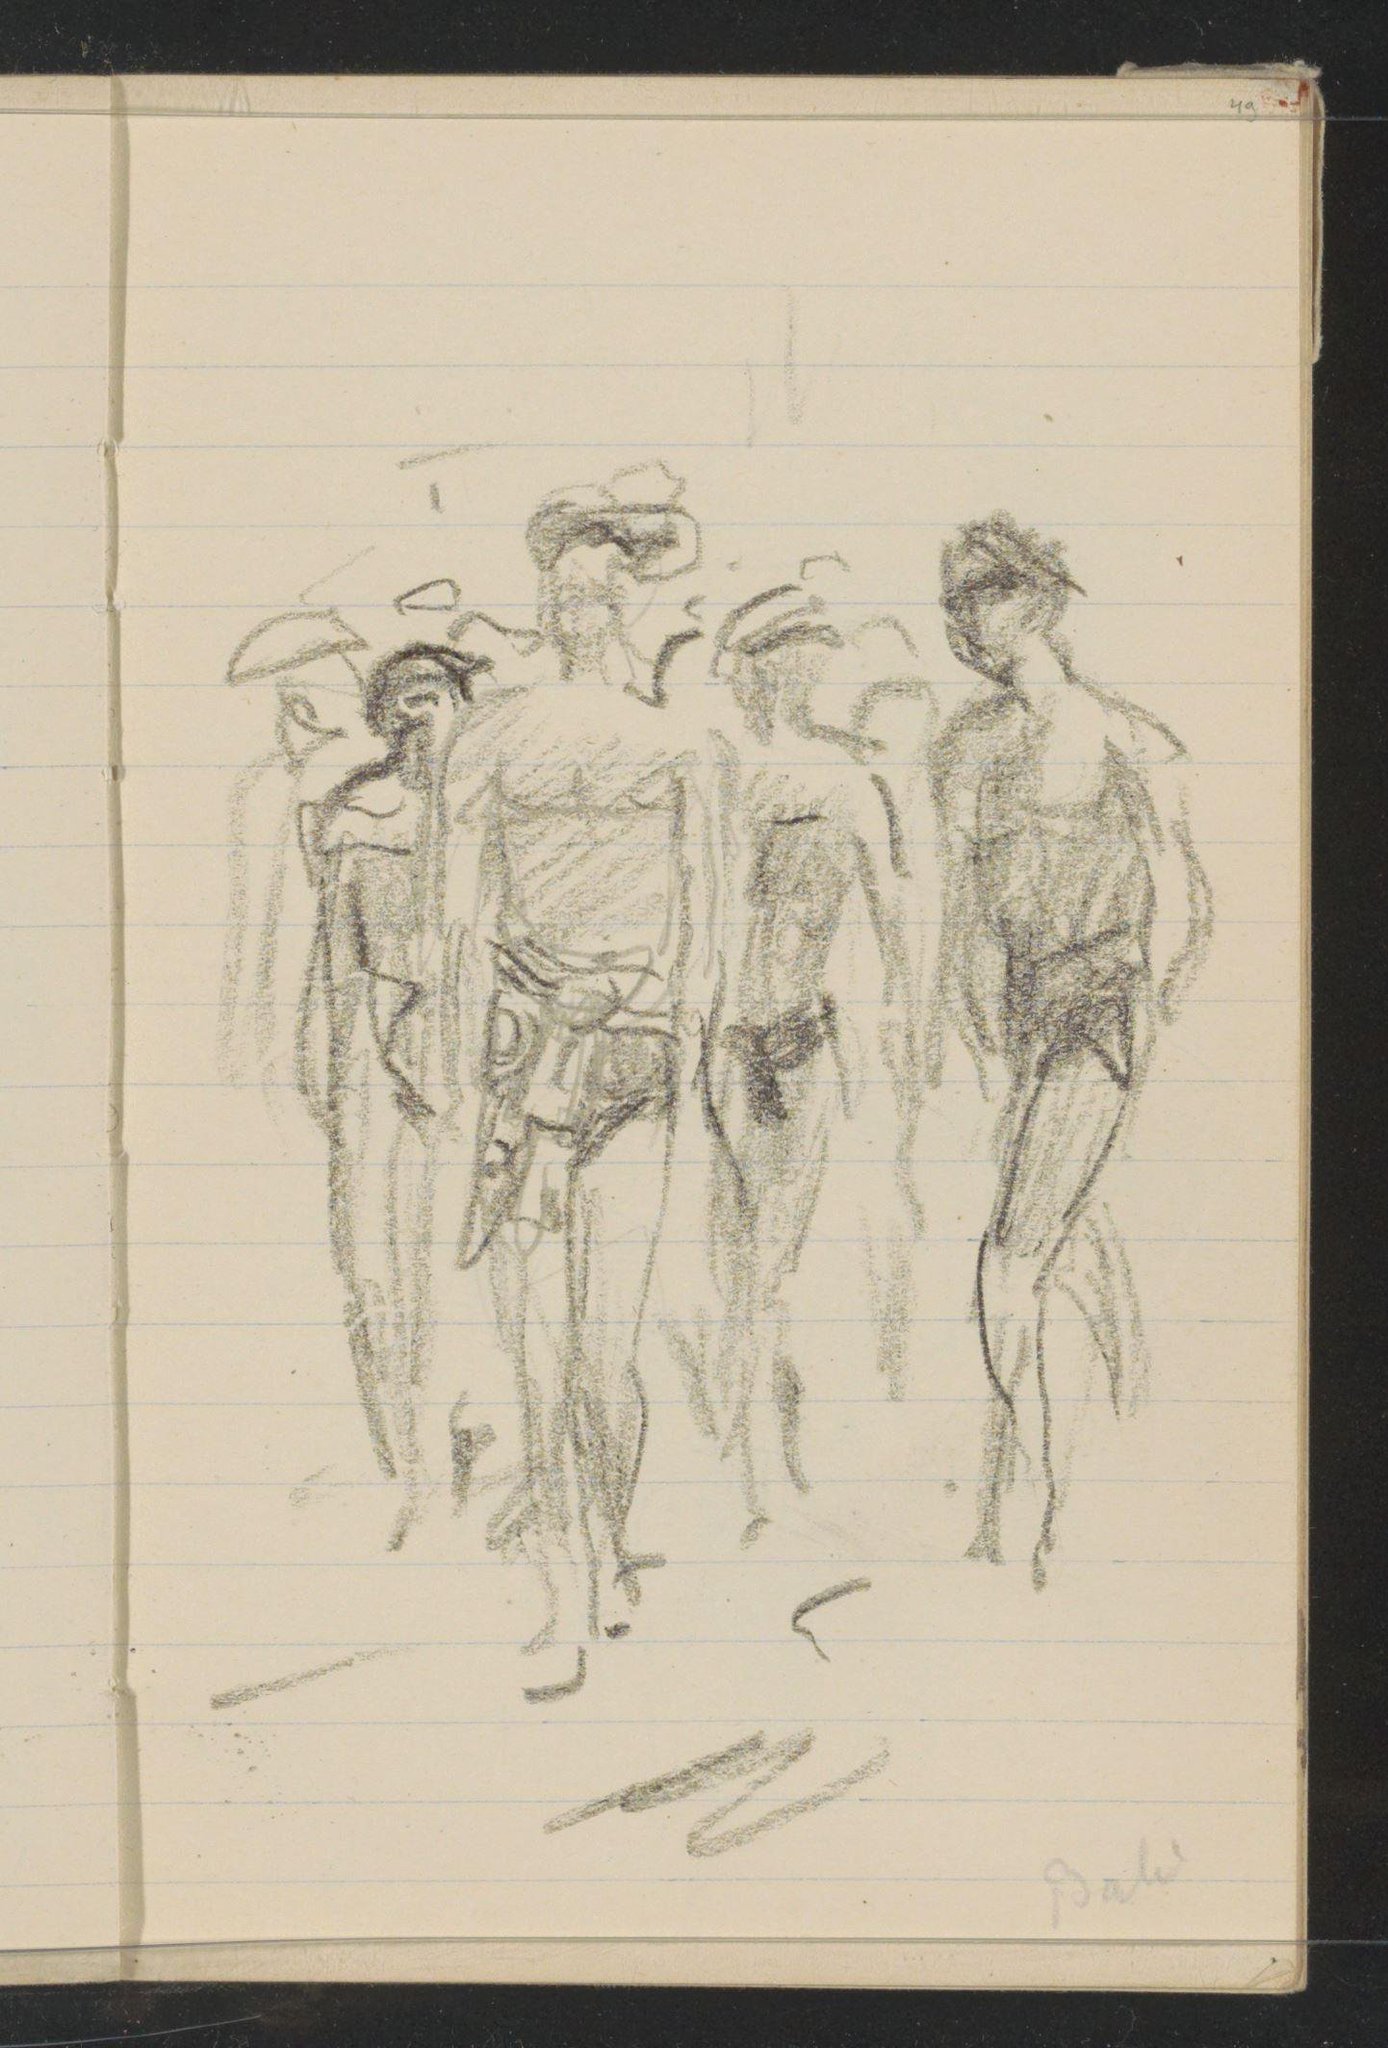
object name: sketchbook leaf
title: Balinese mannen in lendendoeken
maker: marius bauer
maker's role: draughtsman, print maker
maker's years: 1867-1932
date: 1931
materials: chalk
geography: bali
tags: asiatic races and peoples, adult man, folk costume, regional costume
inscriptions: annotation: ‘Bali’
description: Pagina 49 uit een schetsboek met 74 bladen.